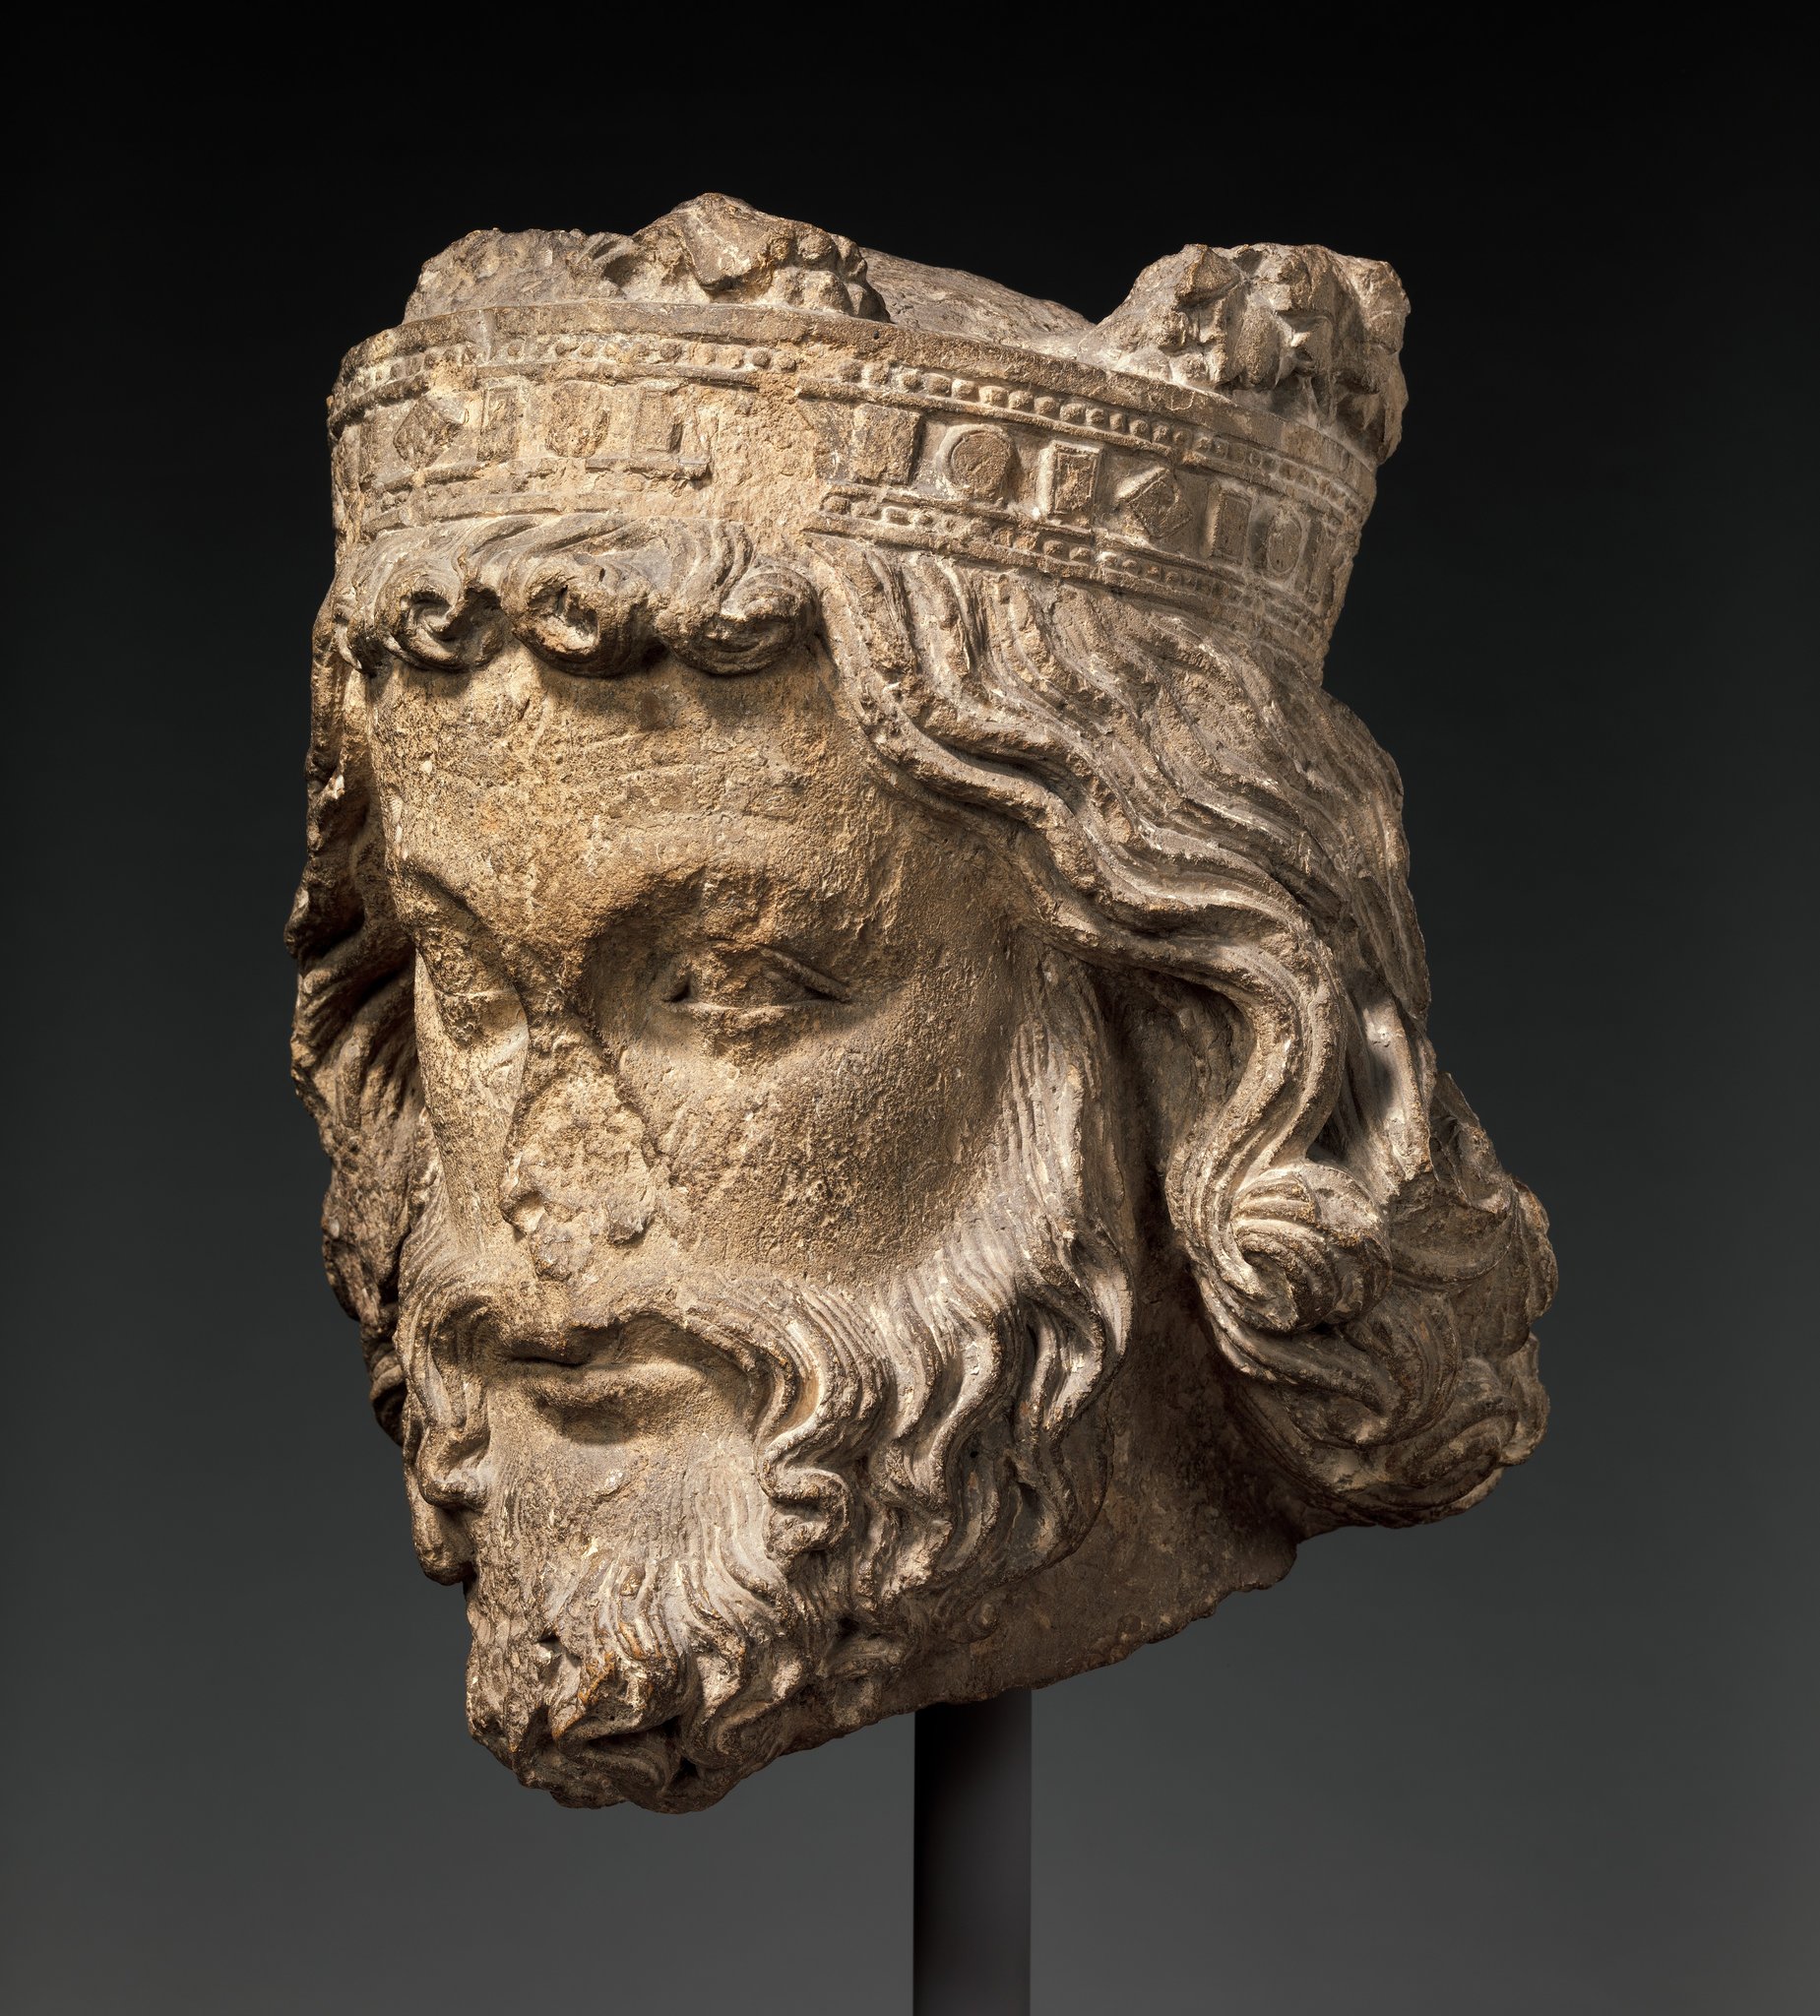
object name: statue head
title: Head of a King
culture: french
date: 1230-1235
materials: limestone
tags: kings